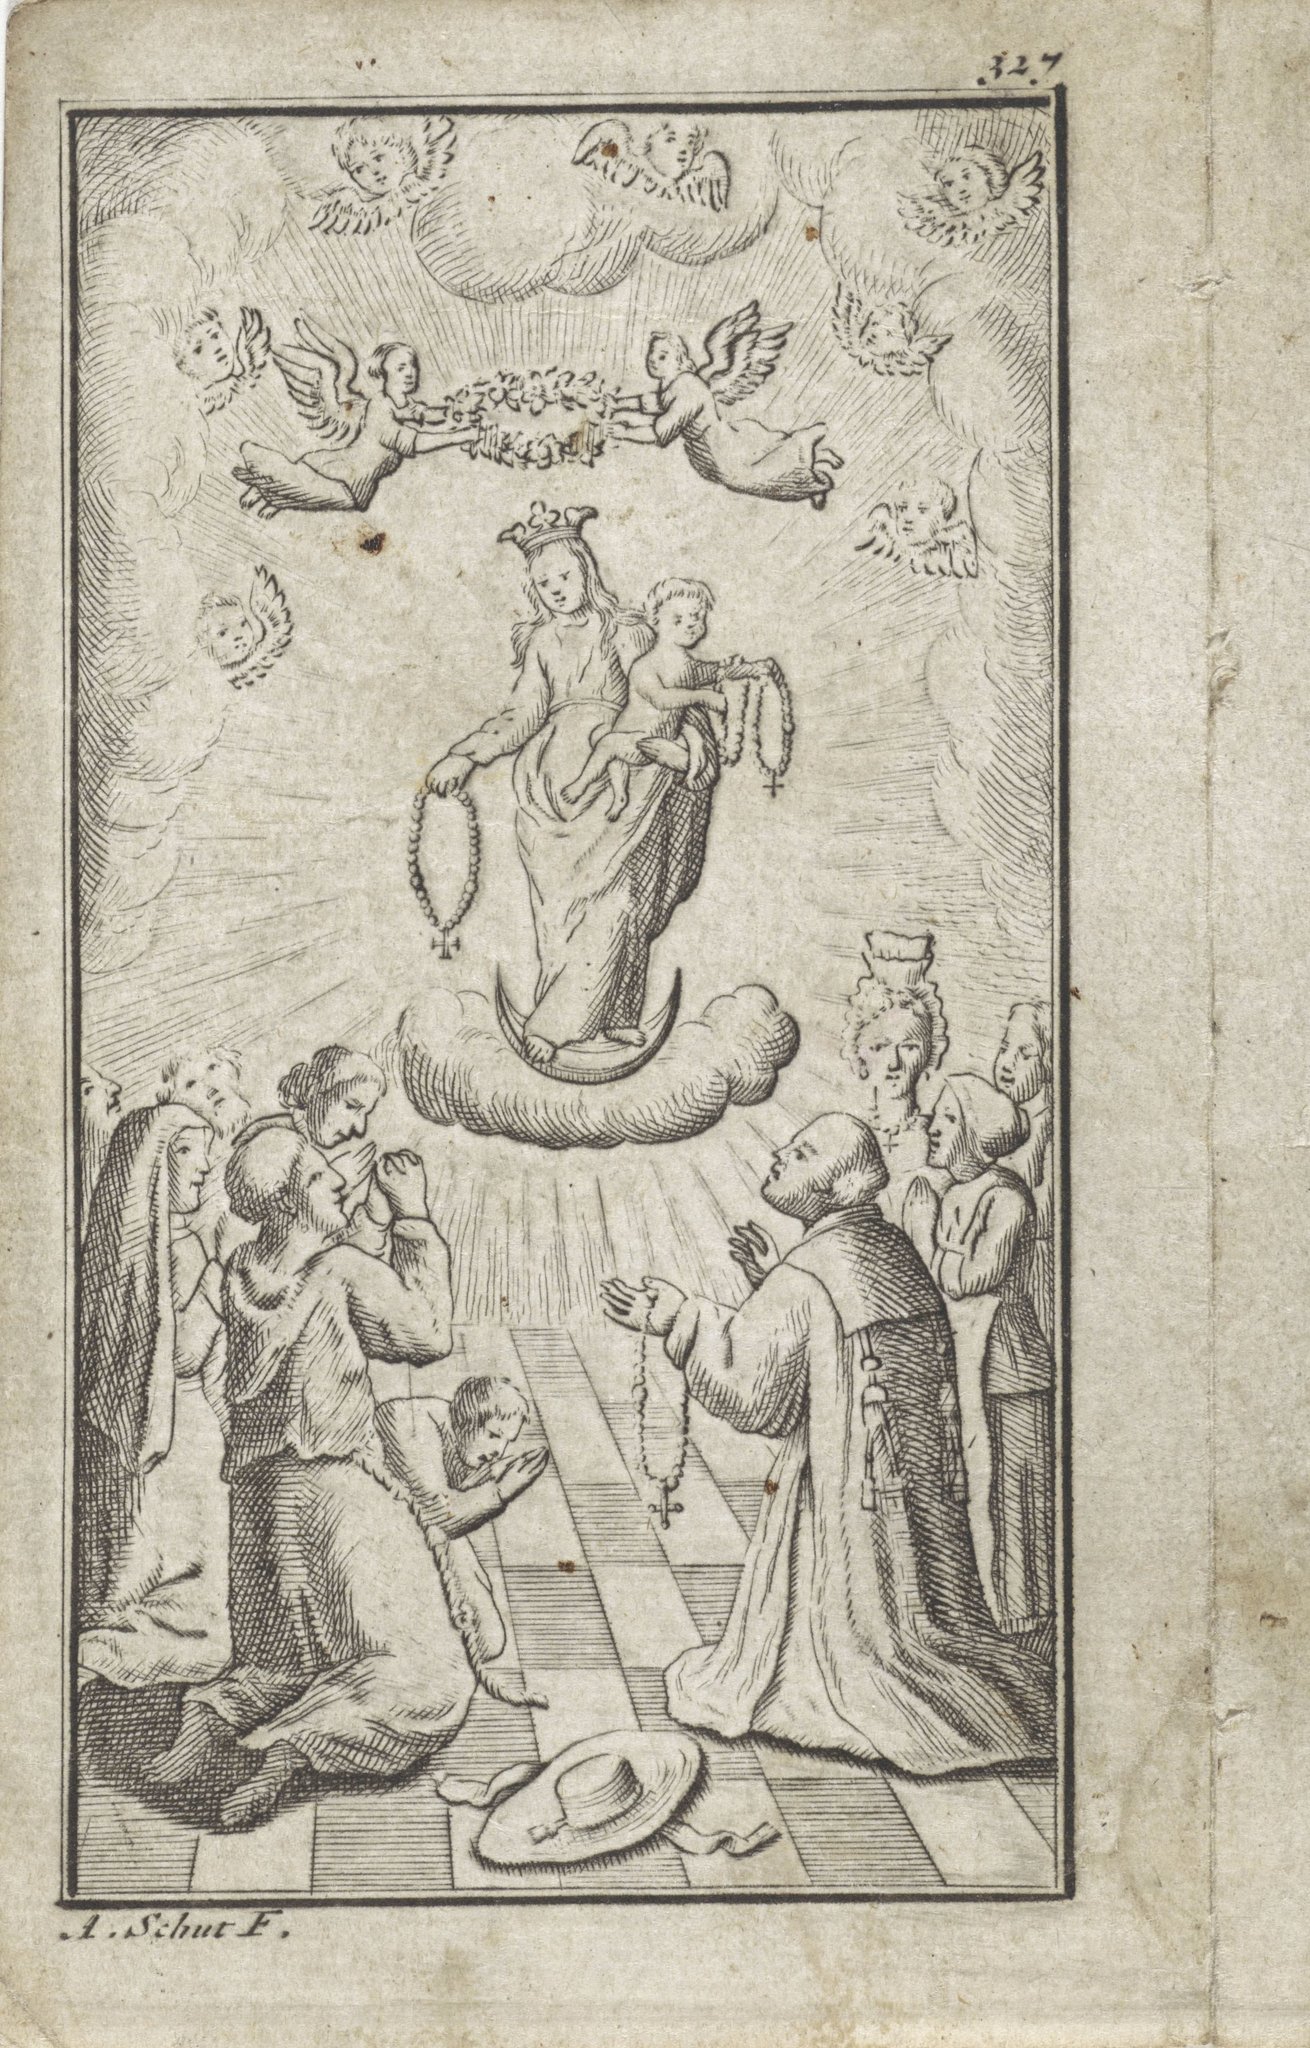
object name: book illustration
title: Aanbidding van Maria en het Christuskind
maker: albert schut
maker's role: print maker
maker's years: 1687-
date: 1708-1713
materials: paper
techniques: engraving, etching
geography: amsterdam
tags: madonna on the crescent of the moon (sometimes called queen of heaven) (in mandorla) (+ angel(s)), aids for prayer, e.g. rosary, mary together with mortals, who adore her, or implore her to help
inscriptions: collector's mark: Lugt 2228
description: Gelovigen knielen in aanbidding voor Maria en het Christuskind. Maria staat op de halvemaan op de wolken. Ze houdt het Kind op de arm. Ze geven rozenkransen aan de gelovigen. Twee engelen lauweren Maria en het Kind. Op de voorgrond ligt een kardinaalshoed. Rechtsboven genummerd: 327.